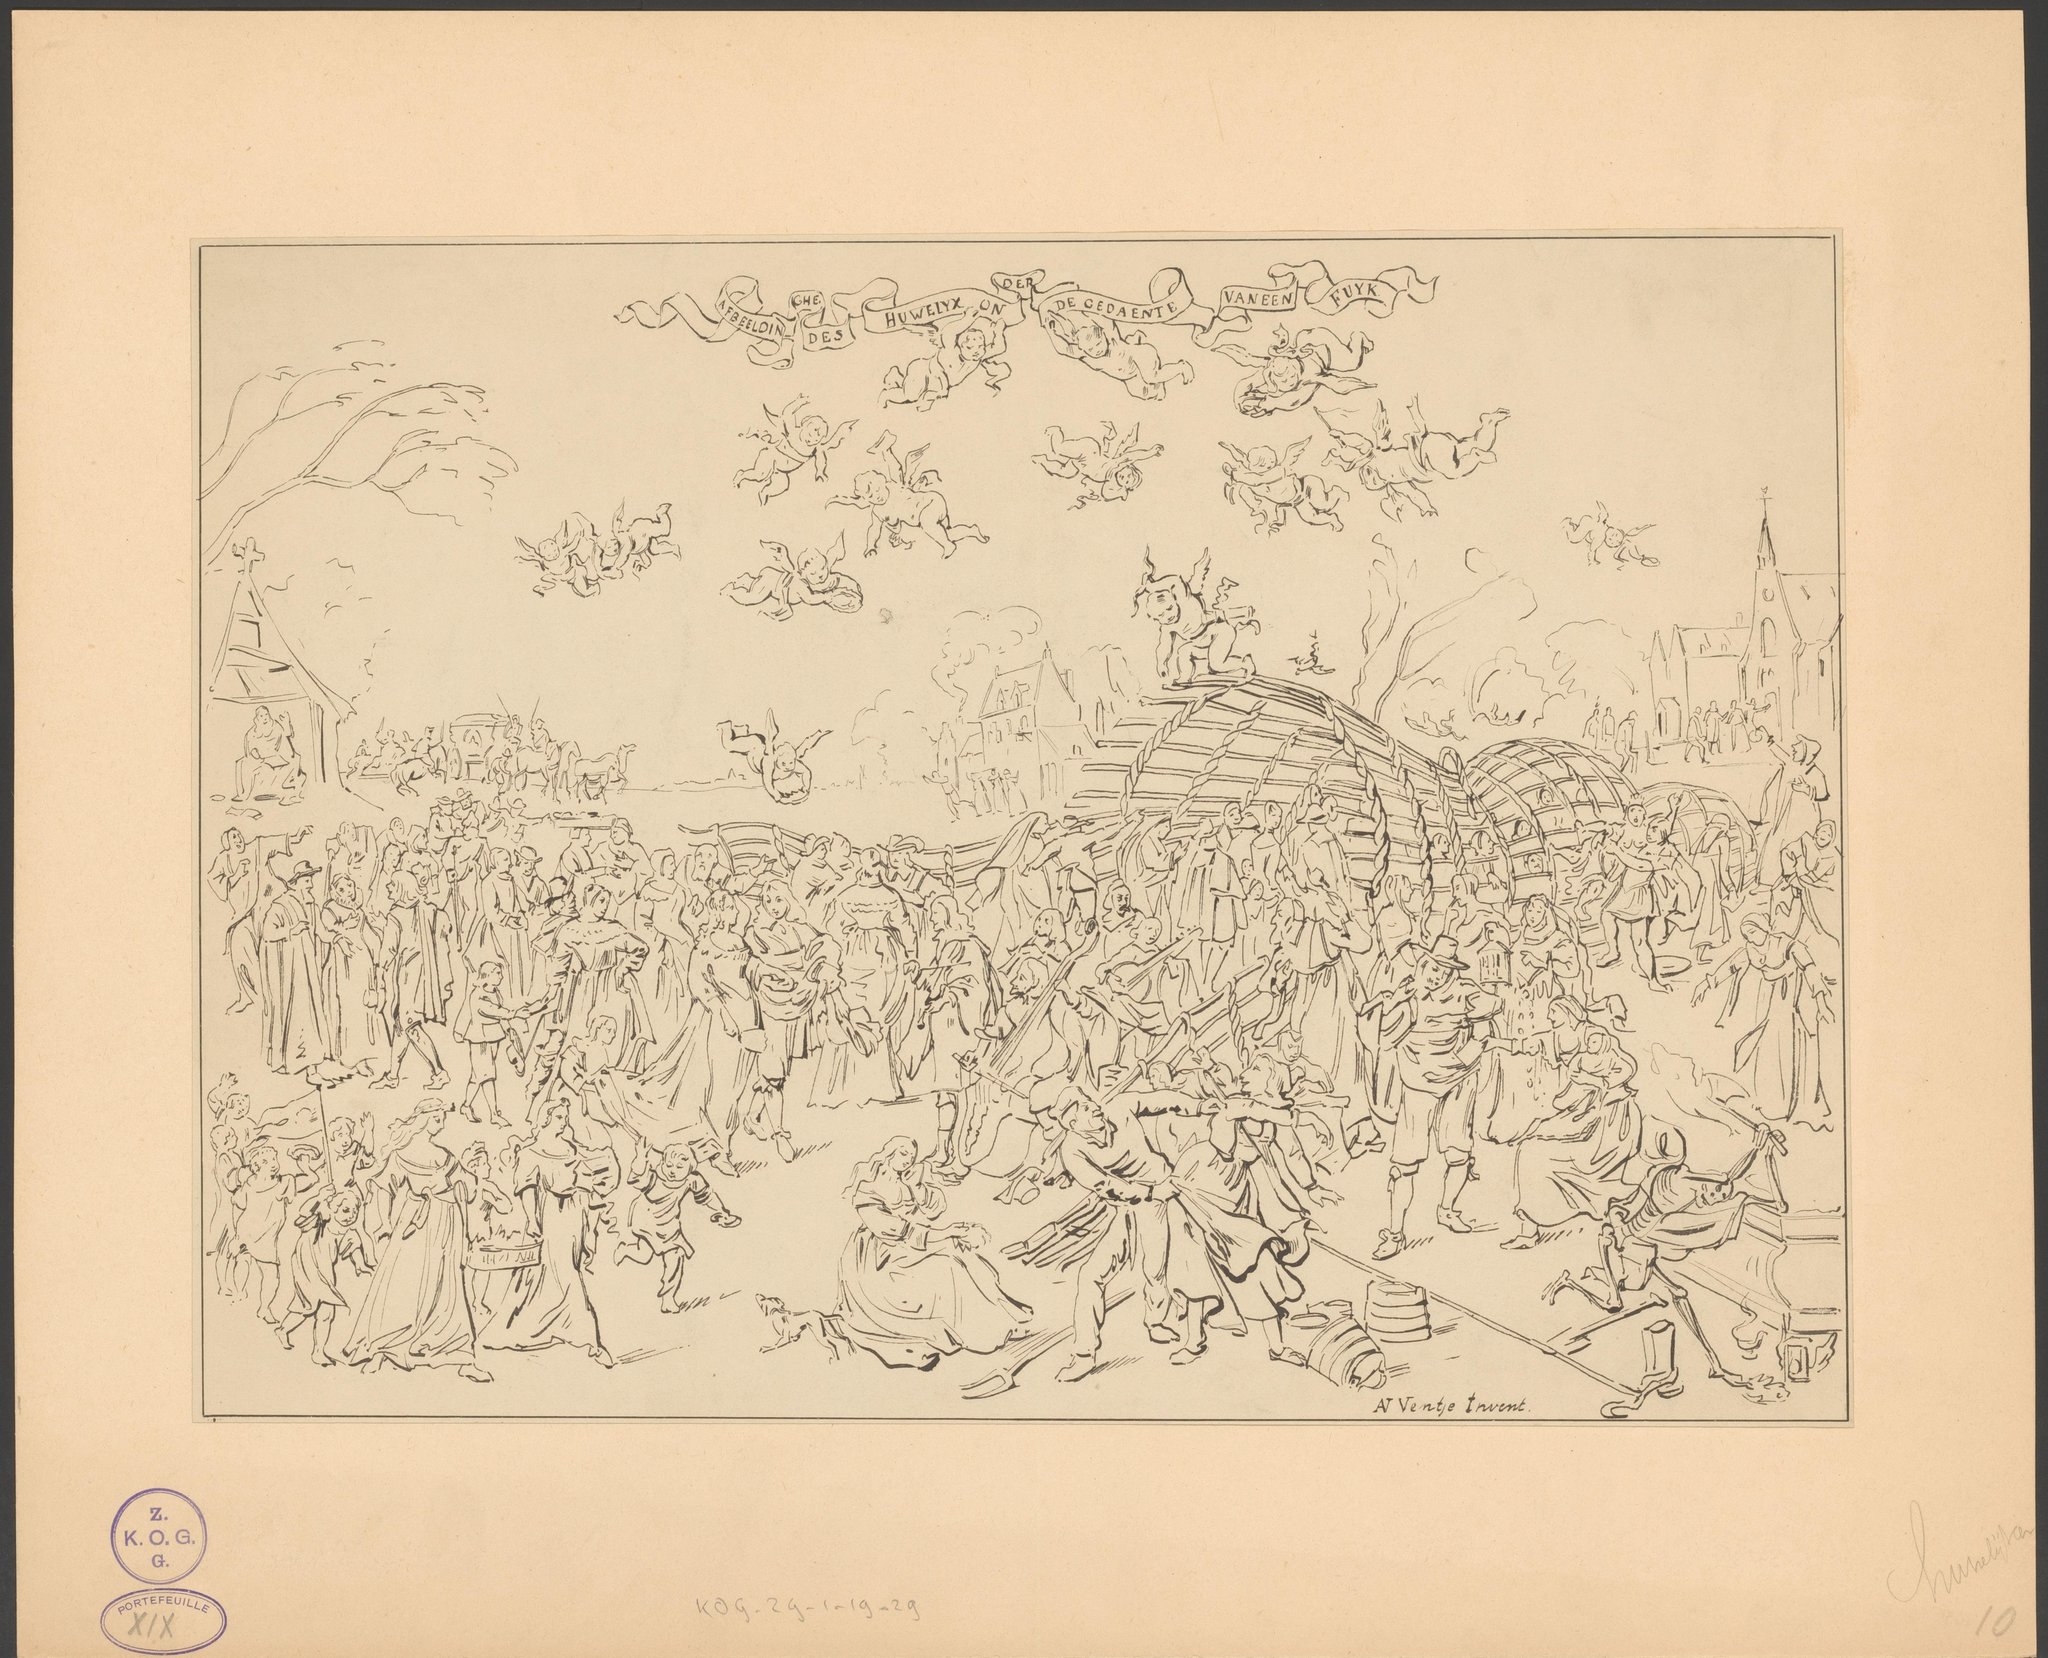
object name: print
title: De huwelijksfuik: allegorie op het huwelijk (kopie)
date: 1800-1899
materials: paper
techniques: lithograph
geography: netherlands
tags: marriage as trap, snare, etc., marriage, married couple, 'matrimonium'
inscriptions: collector's mark: Lugt 1641, collector's mark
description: Kopie in contouren naar de prent van de huwelijksfuik, allegorie op het huwelijk. Onderwerpsrubrieken binnen de Atlas Zeden en Gewoonten: Des Menschen Begin, Midden en Einde. Bruiloft en huwelijk.